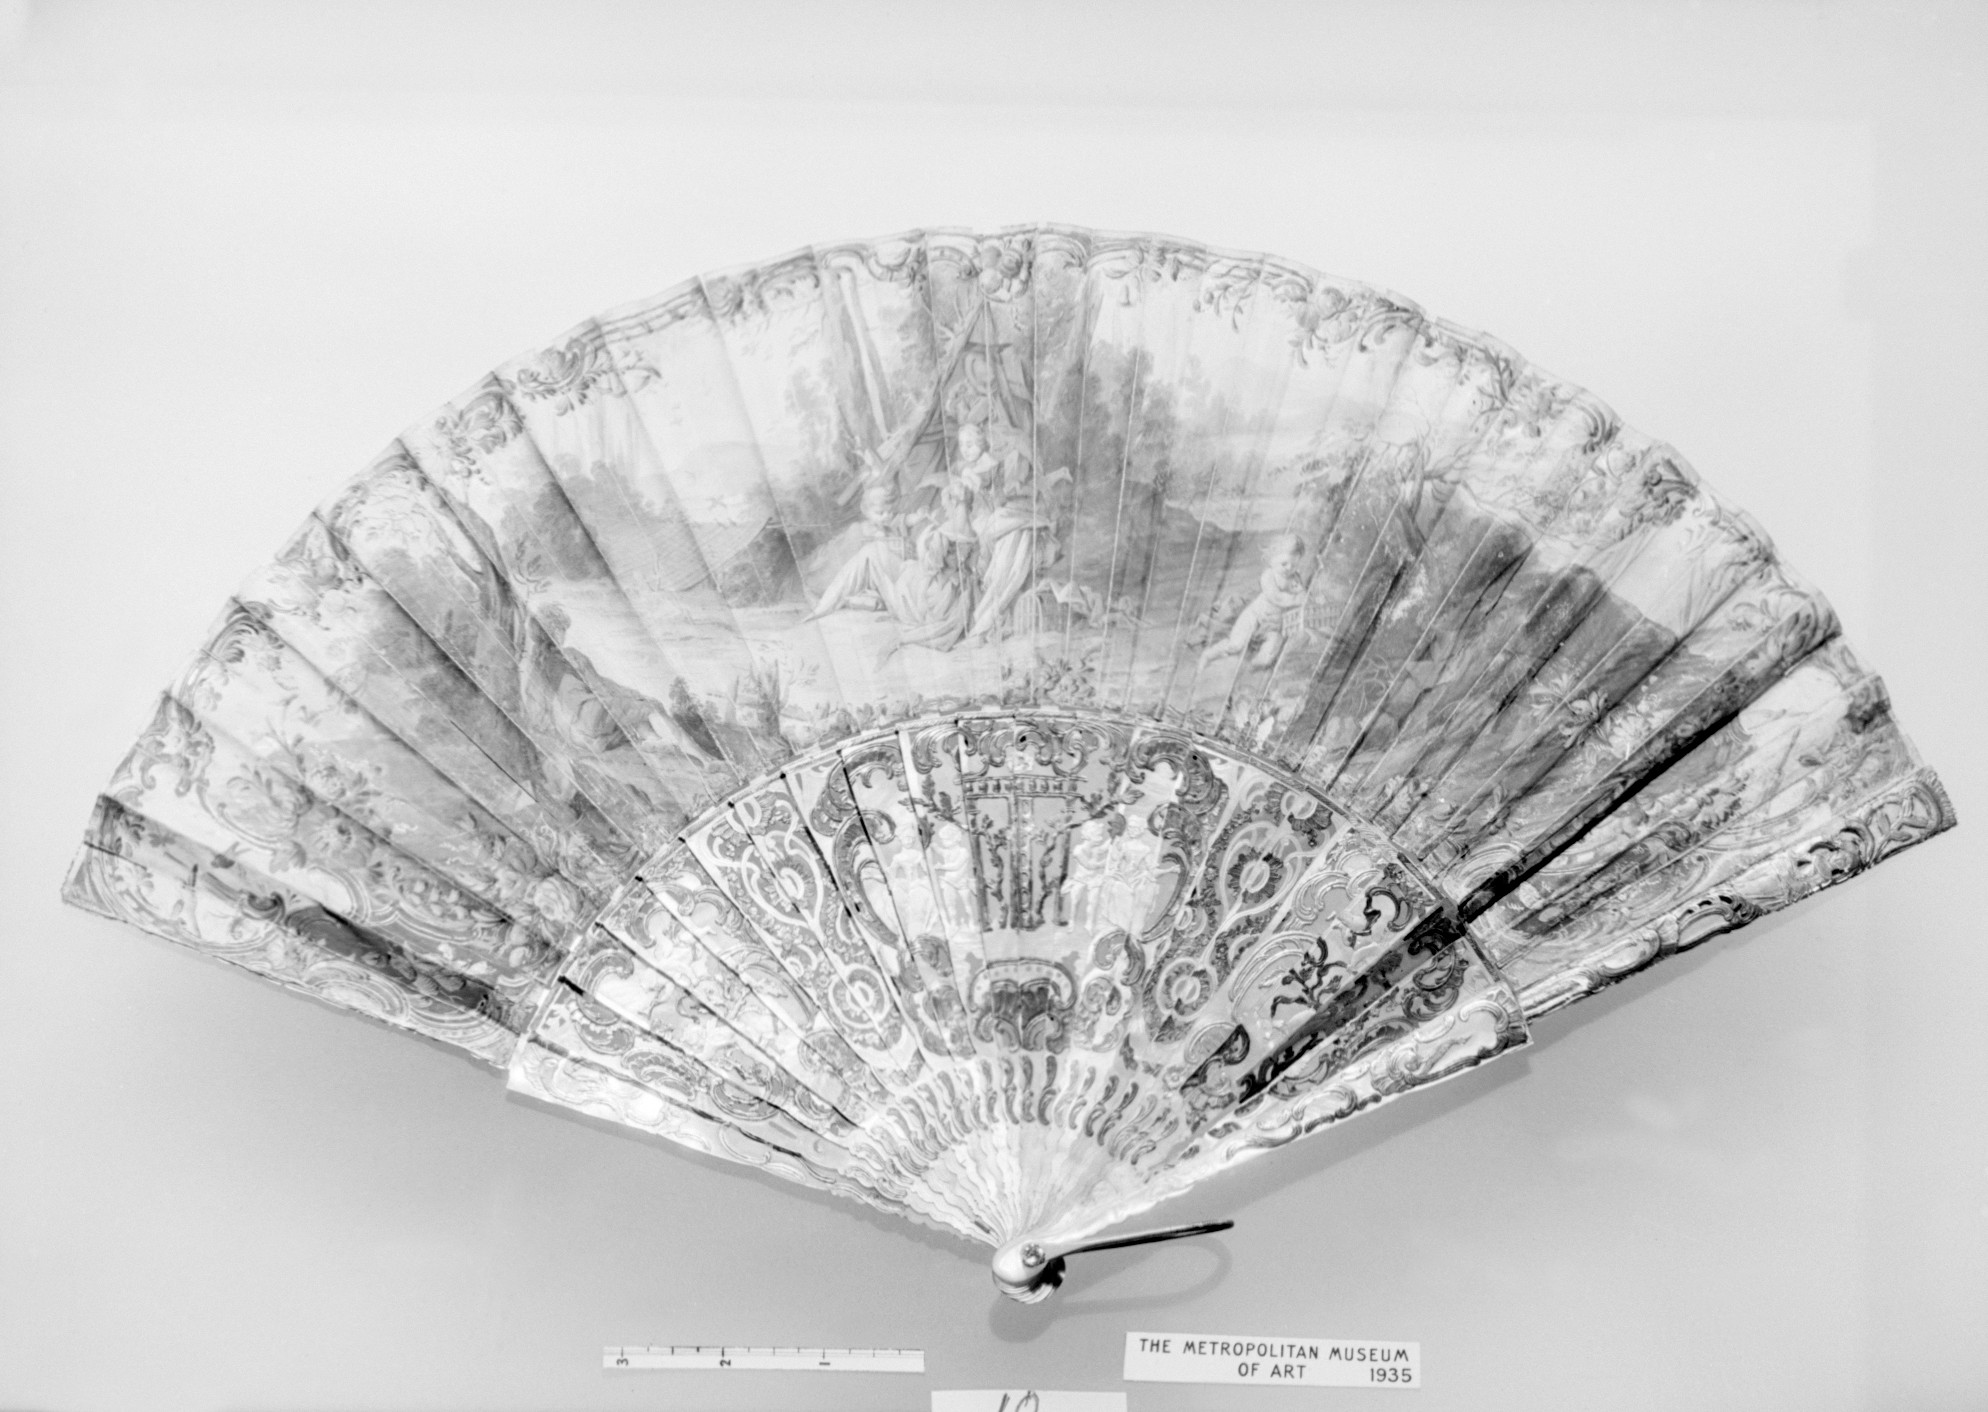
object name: fan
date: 1751-1775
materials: mother of pearl, paper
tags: women,putti